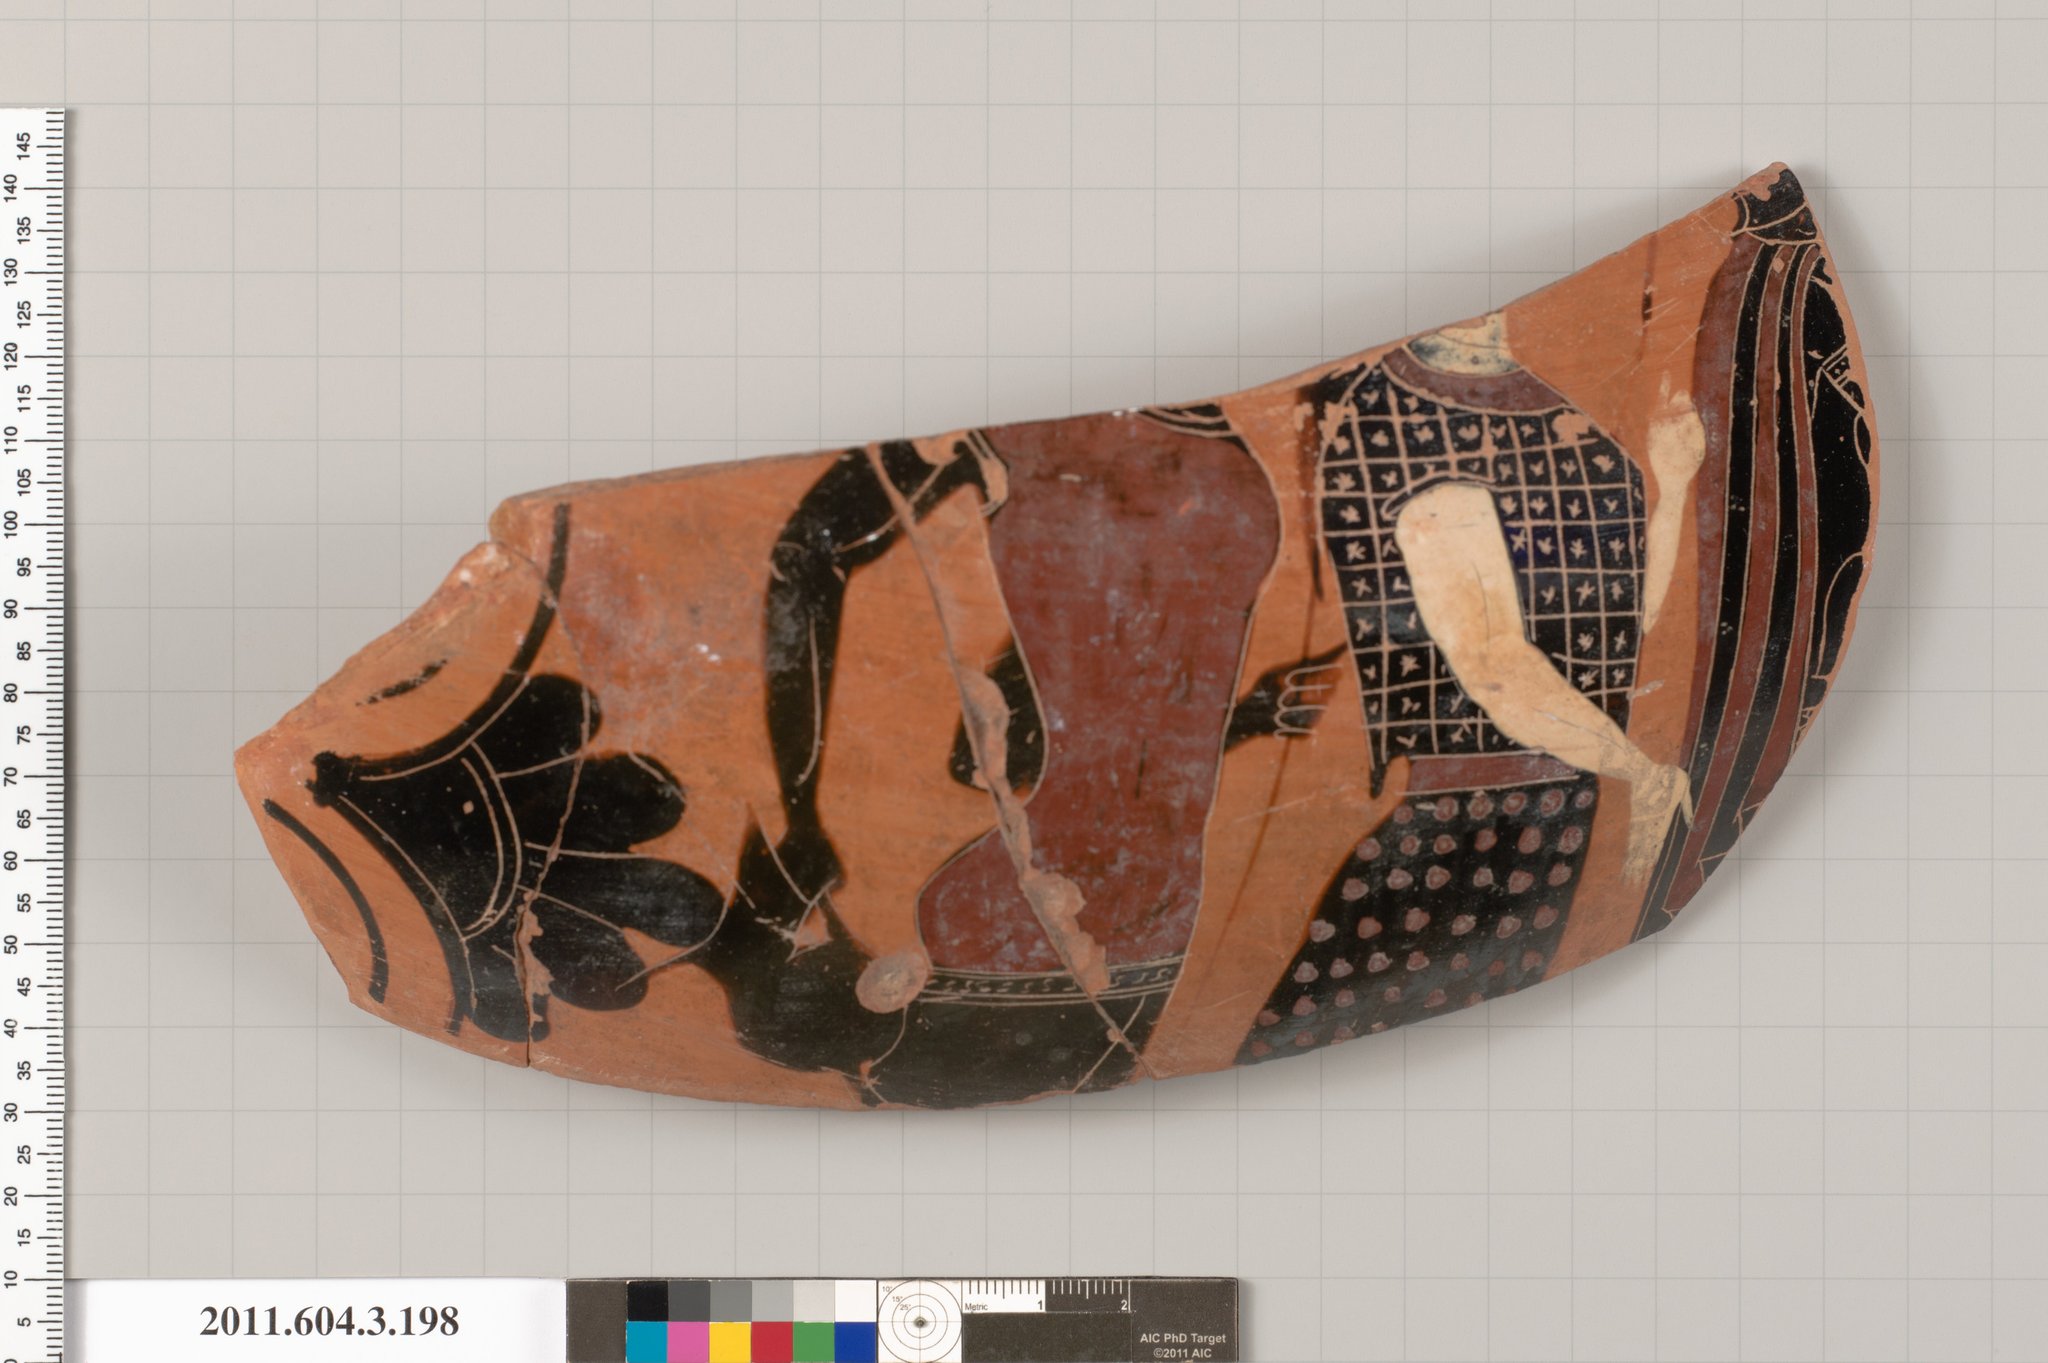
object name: neck amphora fragment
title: Terracotta fragment of a neck-amphora (jar)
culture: greek, attic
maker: painter of vatican 365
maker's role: artist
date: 540-530 BCE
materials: terracotta